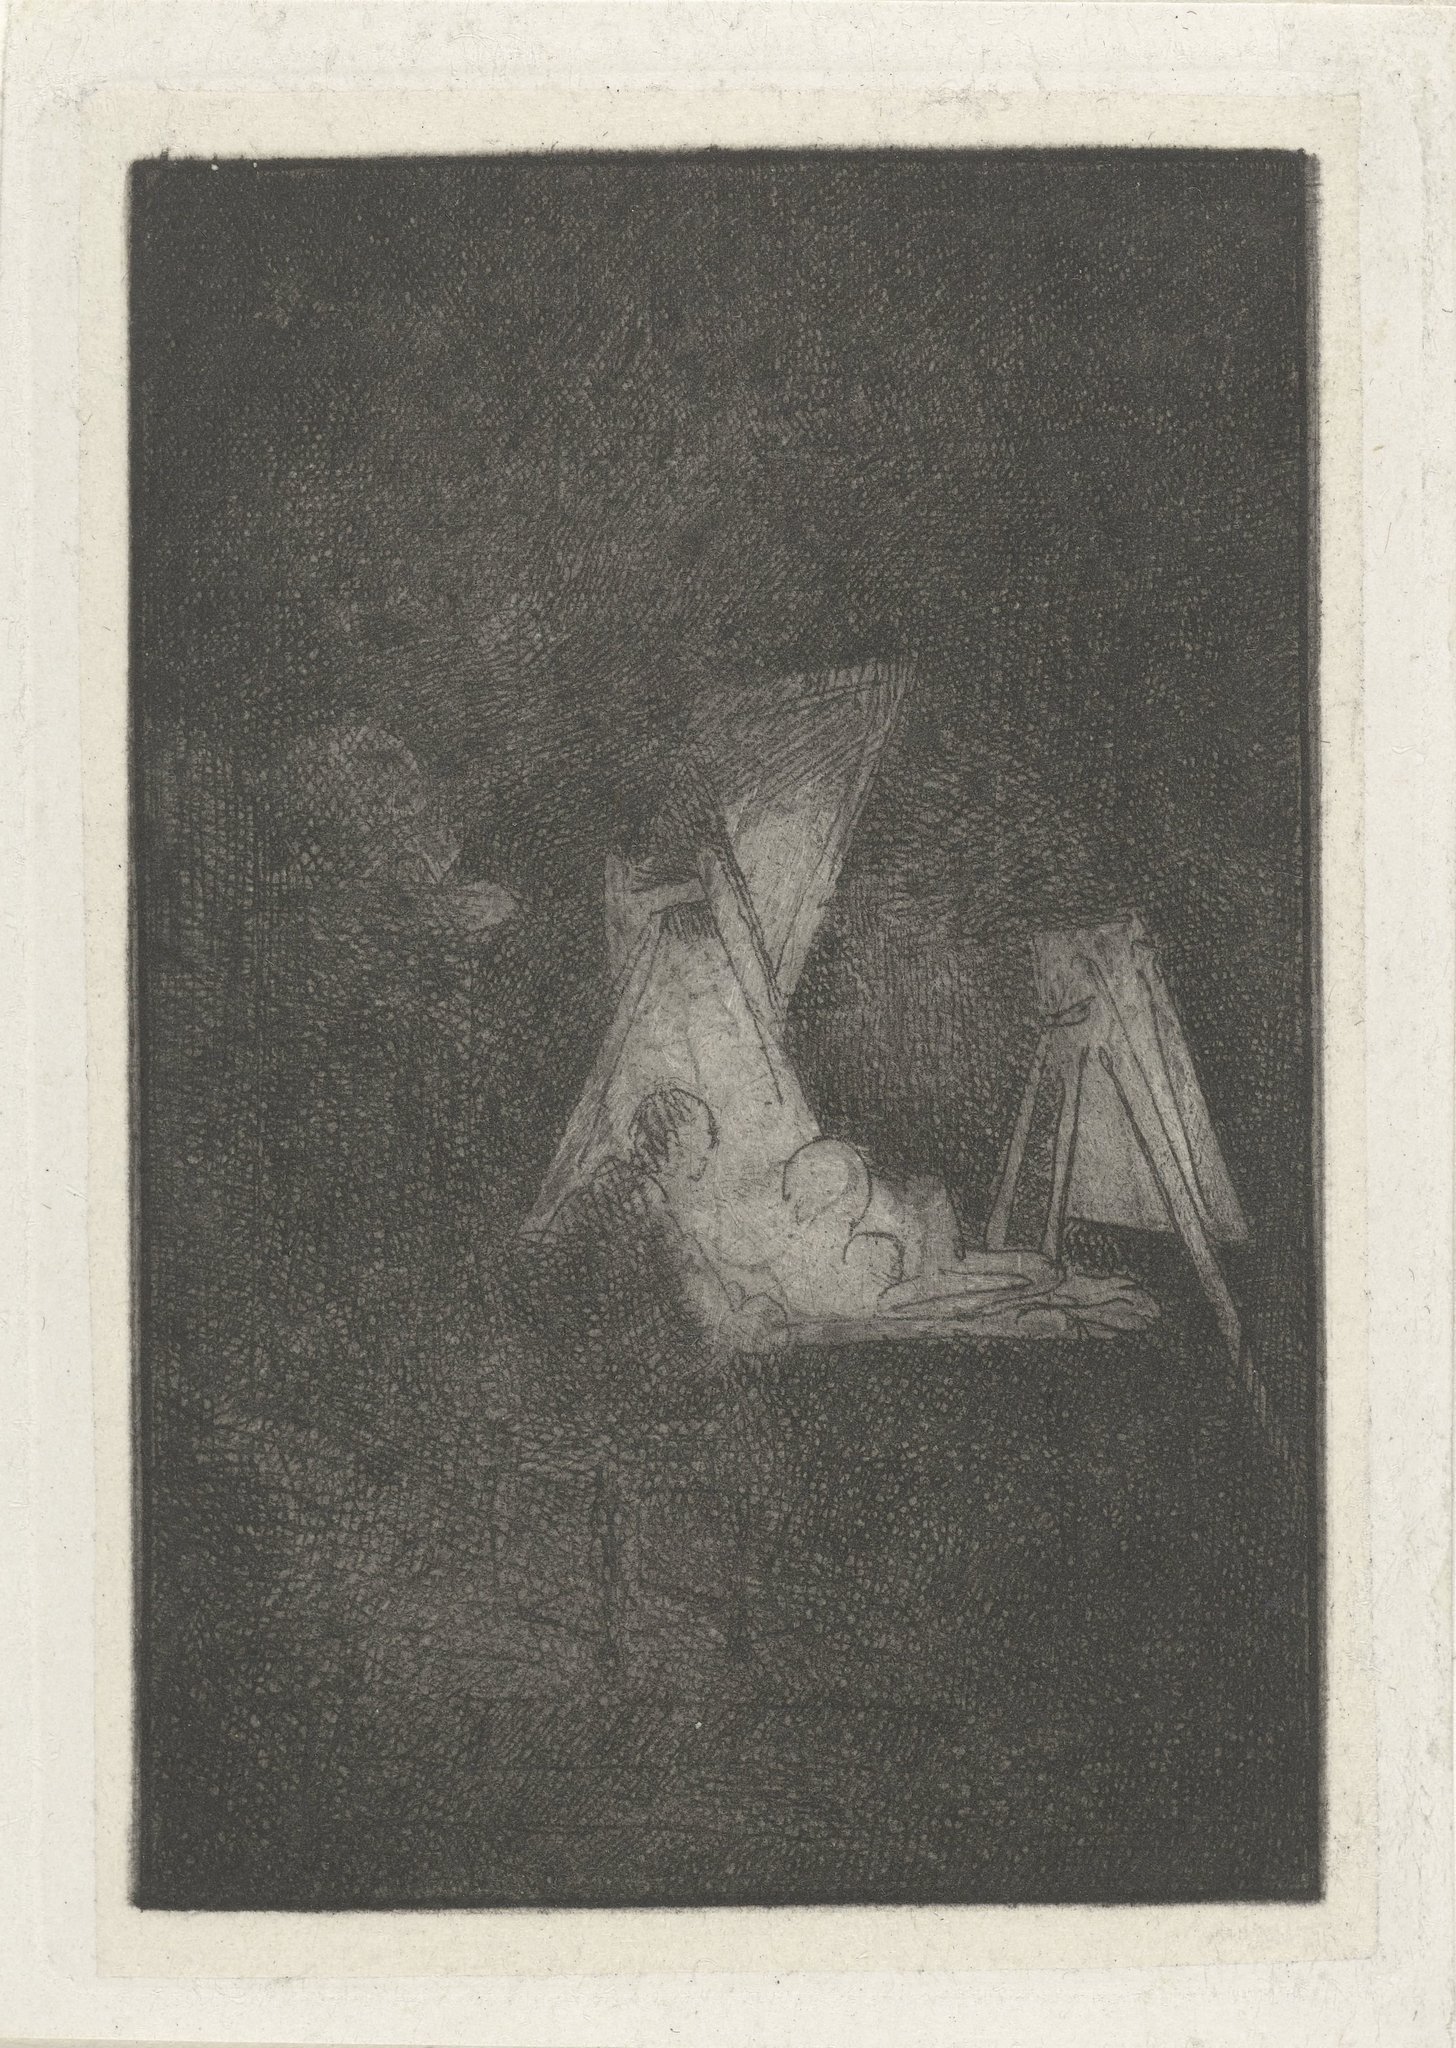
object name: print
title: Kunstenaar in zijn atelier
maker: jacobus ludovicus cornet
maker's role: draughtsman, print maker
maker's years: 1815-1882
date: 1825-1882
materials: paper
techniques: etching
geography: leiden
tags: artist at work, in his workshop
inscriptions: collector's mark: Lugt 2228